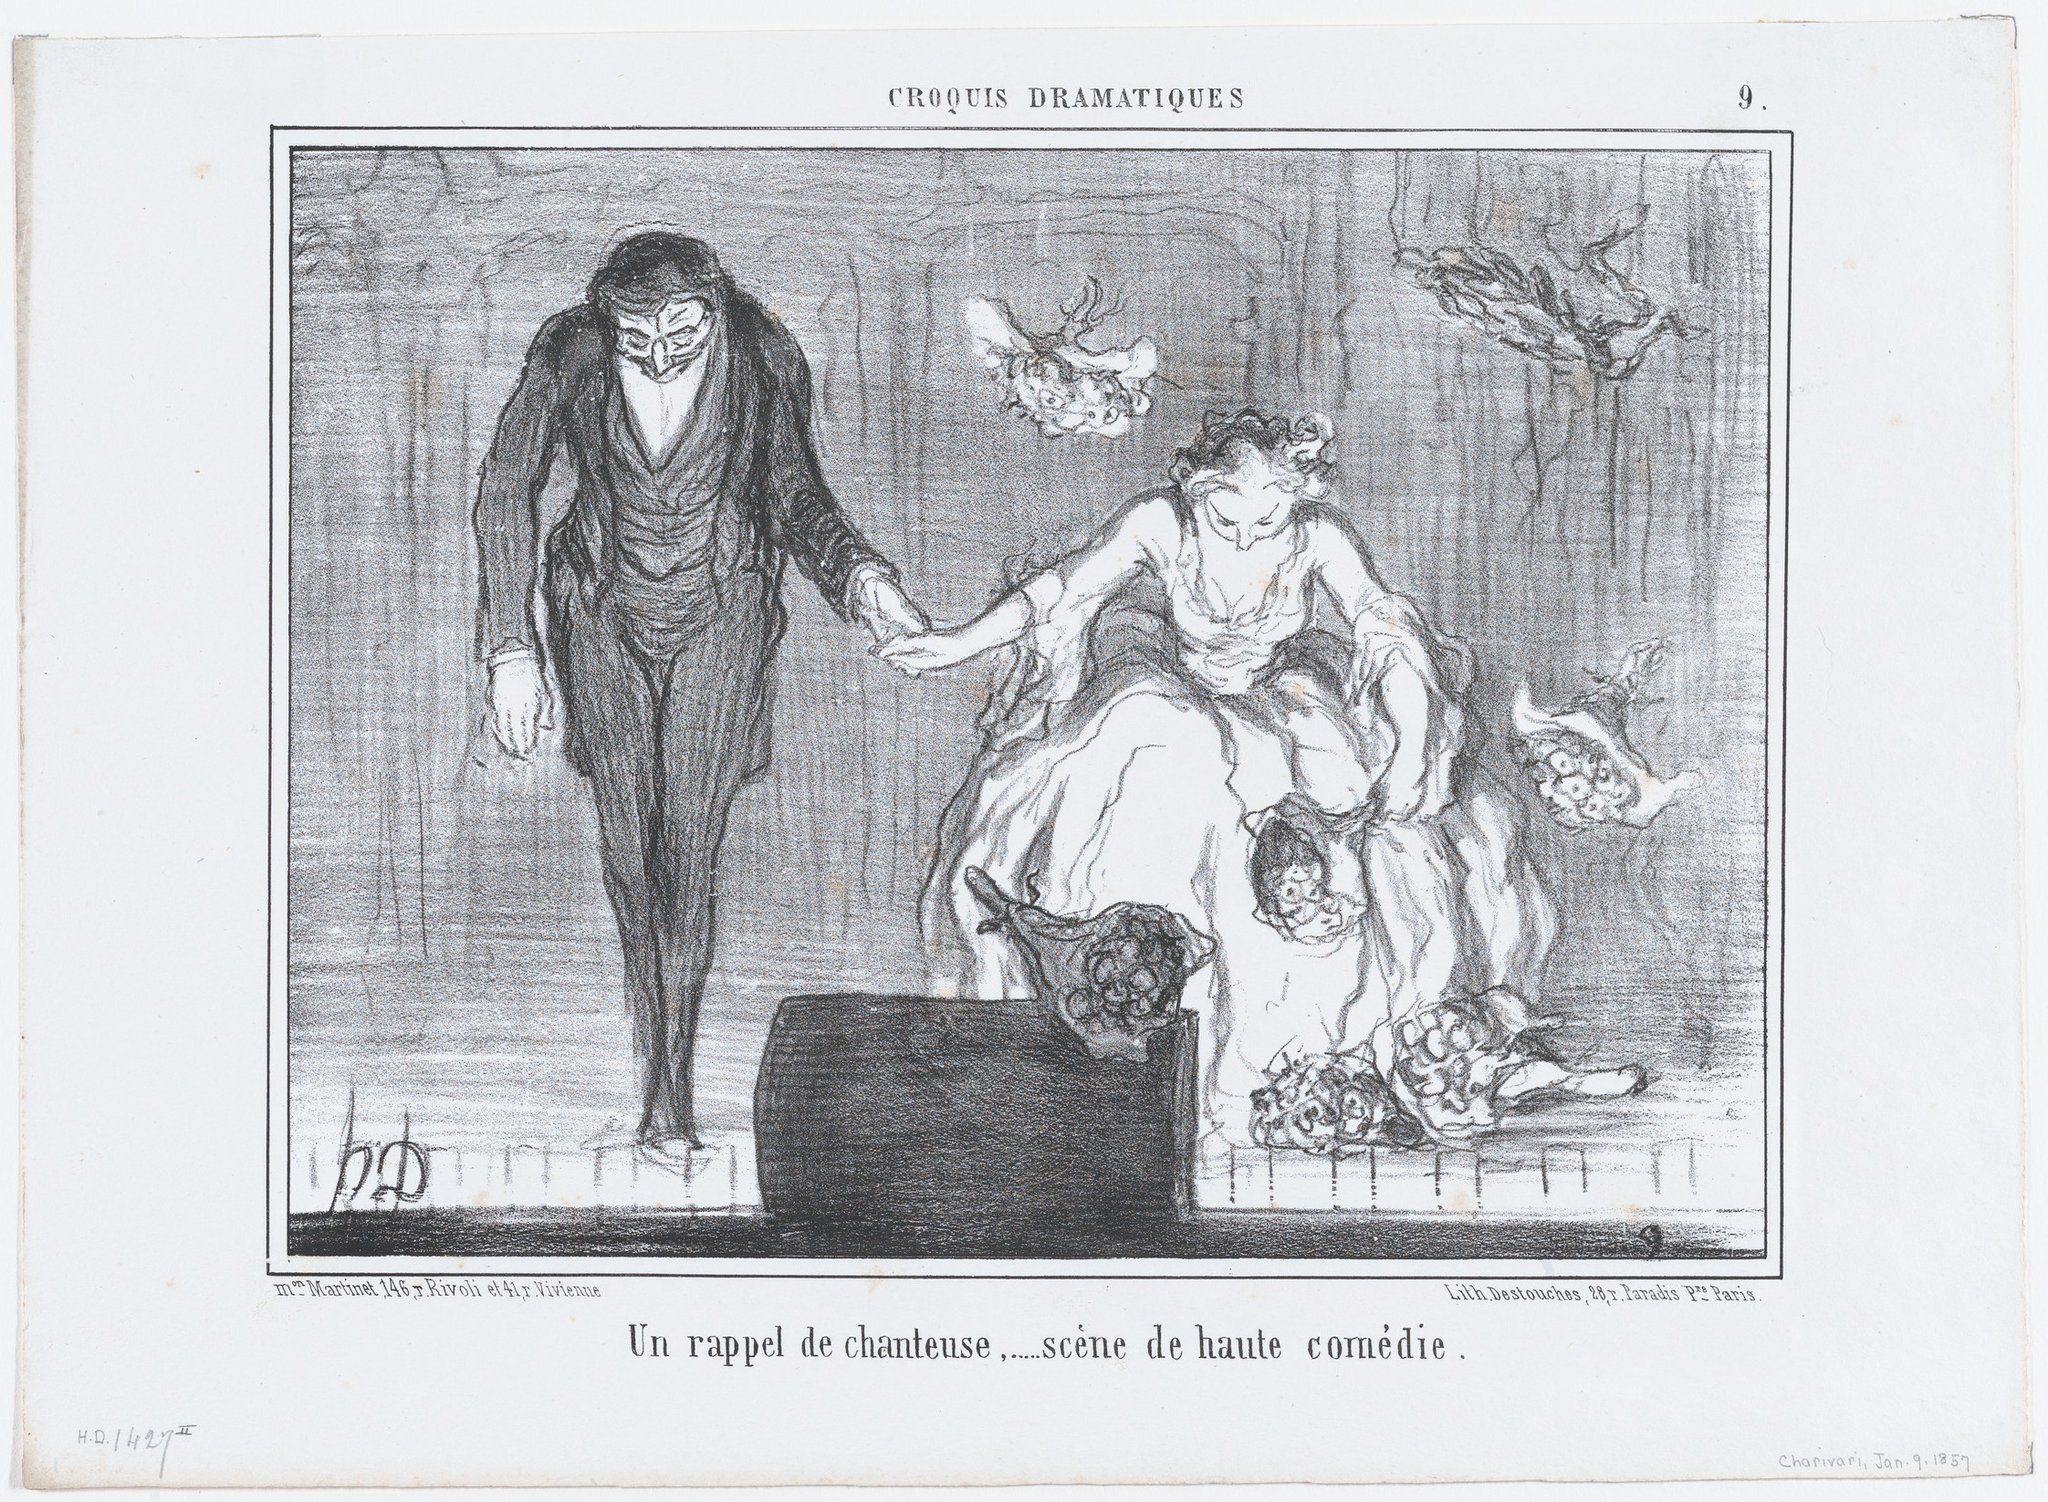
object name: print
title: Un rappel de chanteuse..., from Croquis Dramatiques, published in Le Charivari, January 9, 1857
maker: honoré daumier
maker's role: artist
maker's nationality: french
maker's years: 1808-1879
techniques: lithograph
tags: men,women